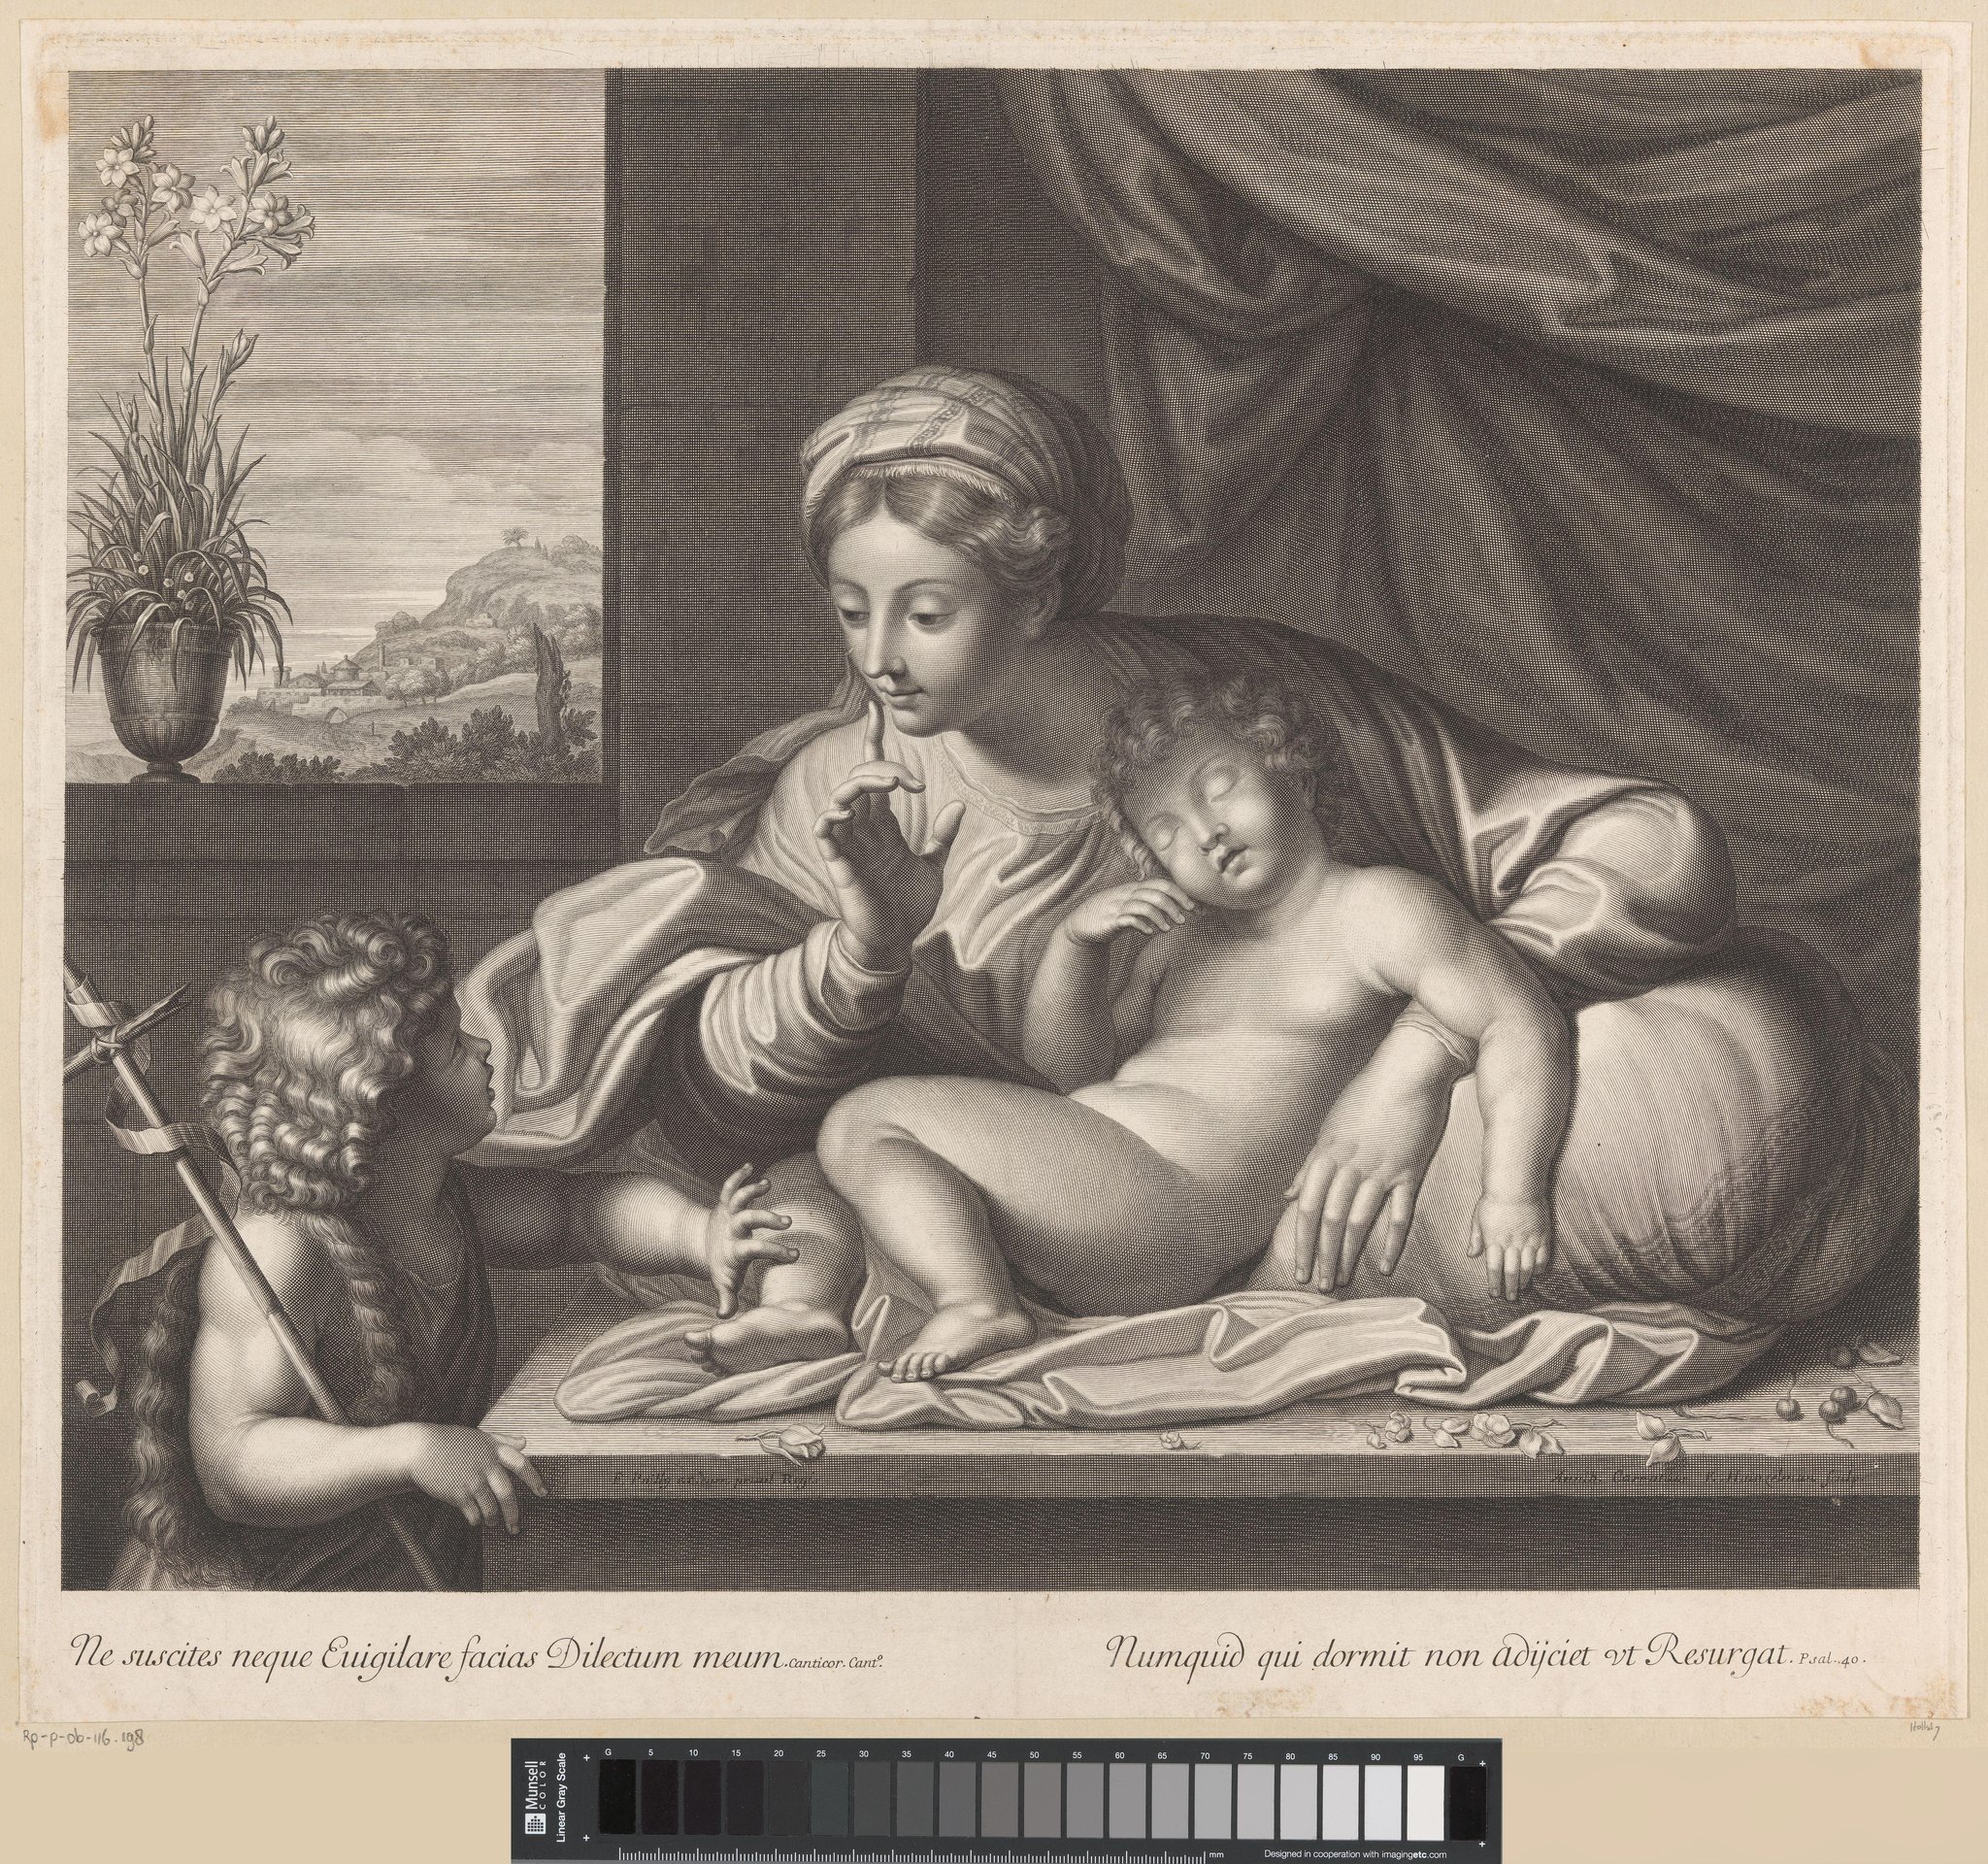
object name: print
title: Madonna del Silenzio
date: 1650-1693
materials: paper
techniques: engraving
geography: regensburg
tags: landscapes, putting a finger to the lips, 'silentium'; 'silentio' (ripa), mary and the christ-child with john the baptist (as child), christ-child sleeping ~ madonna-representations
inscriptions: collector's mark: Lugt 240